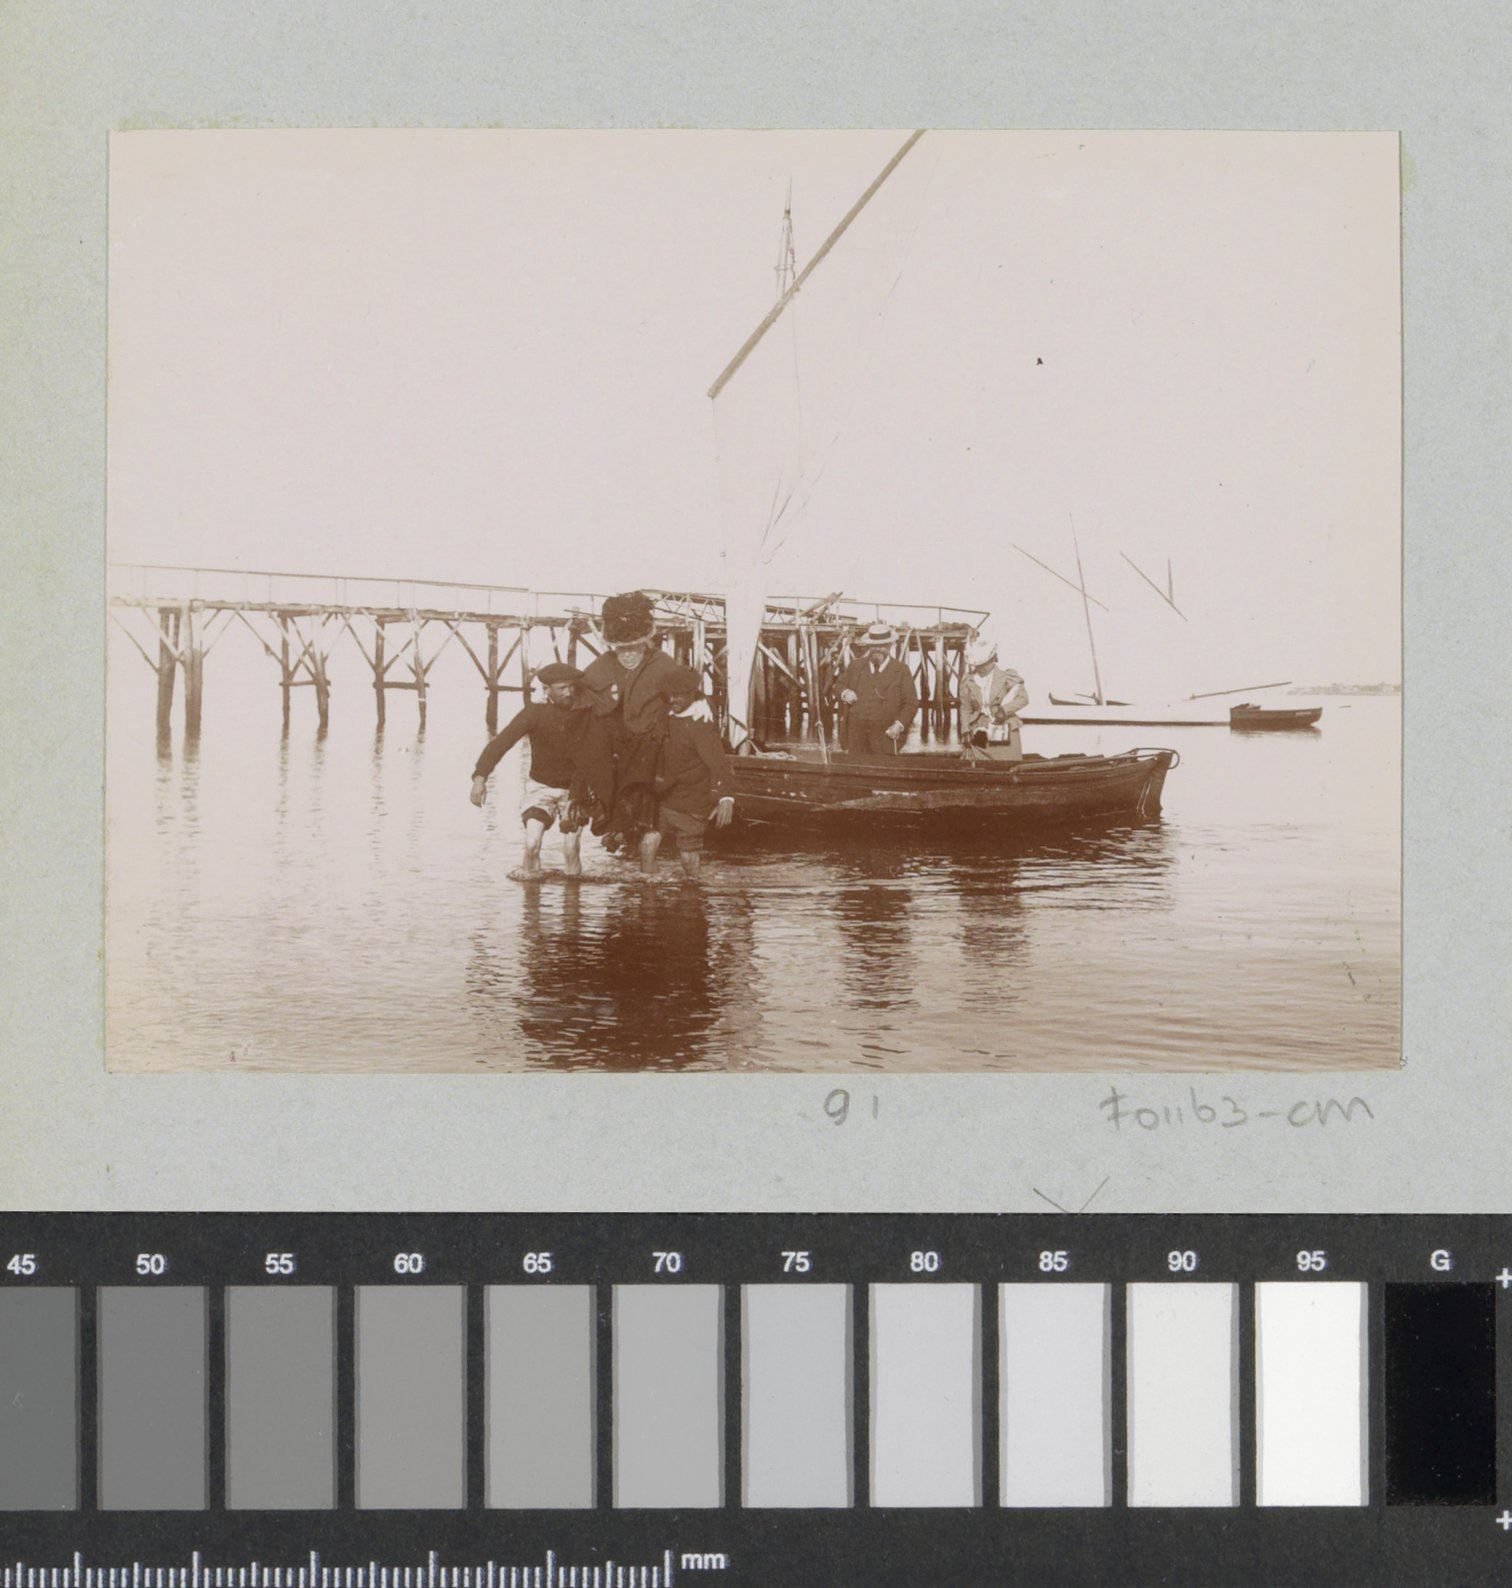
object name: photograph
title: Vrouw wordt uit zeilboot naar de oever gedragen, vermoedelijk ter hoogte van Le Moulleau bij Arcachon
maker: delizy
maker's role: manufacturer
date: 1803-1897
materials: paper, photographic support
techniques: gelatin silver print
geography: arcachon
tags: sailing-ship, sailing-boat, carrying a person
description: Onderdeel van Fotoalbum van een Franse amateurfotograaf met opnames van uitstapjes in Frankrijk, Spanje, België, Luxemburg en Nederland, de eerste automobielen en autoraces.